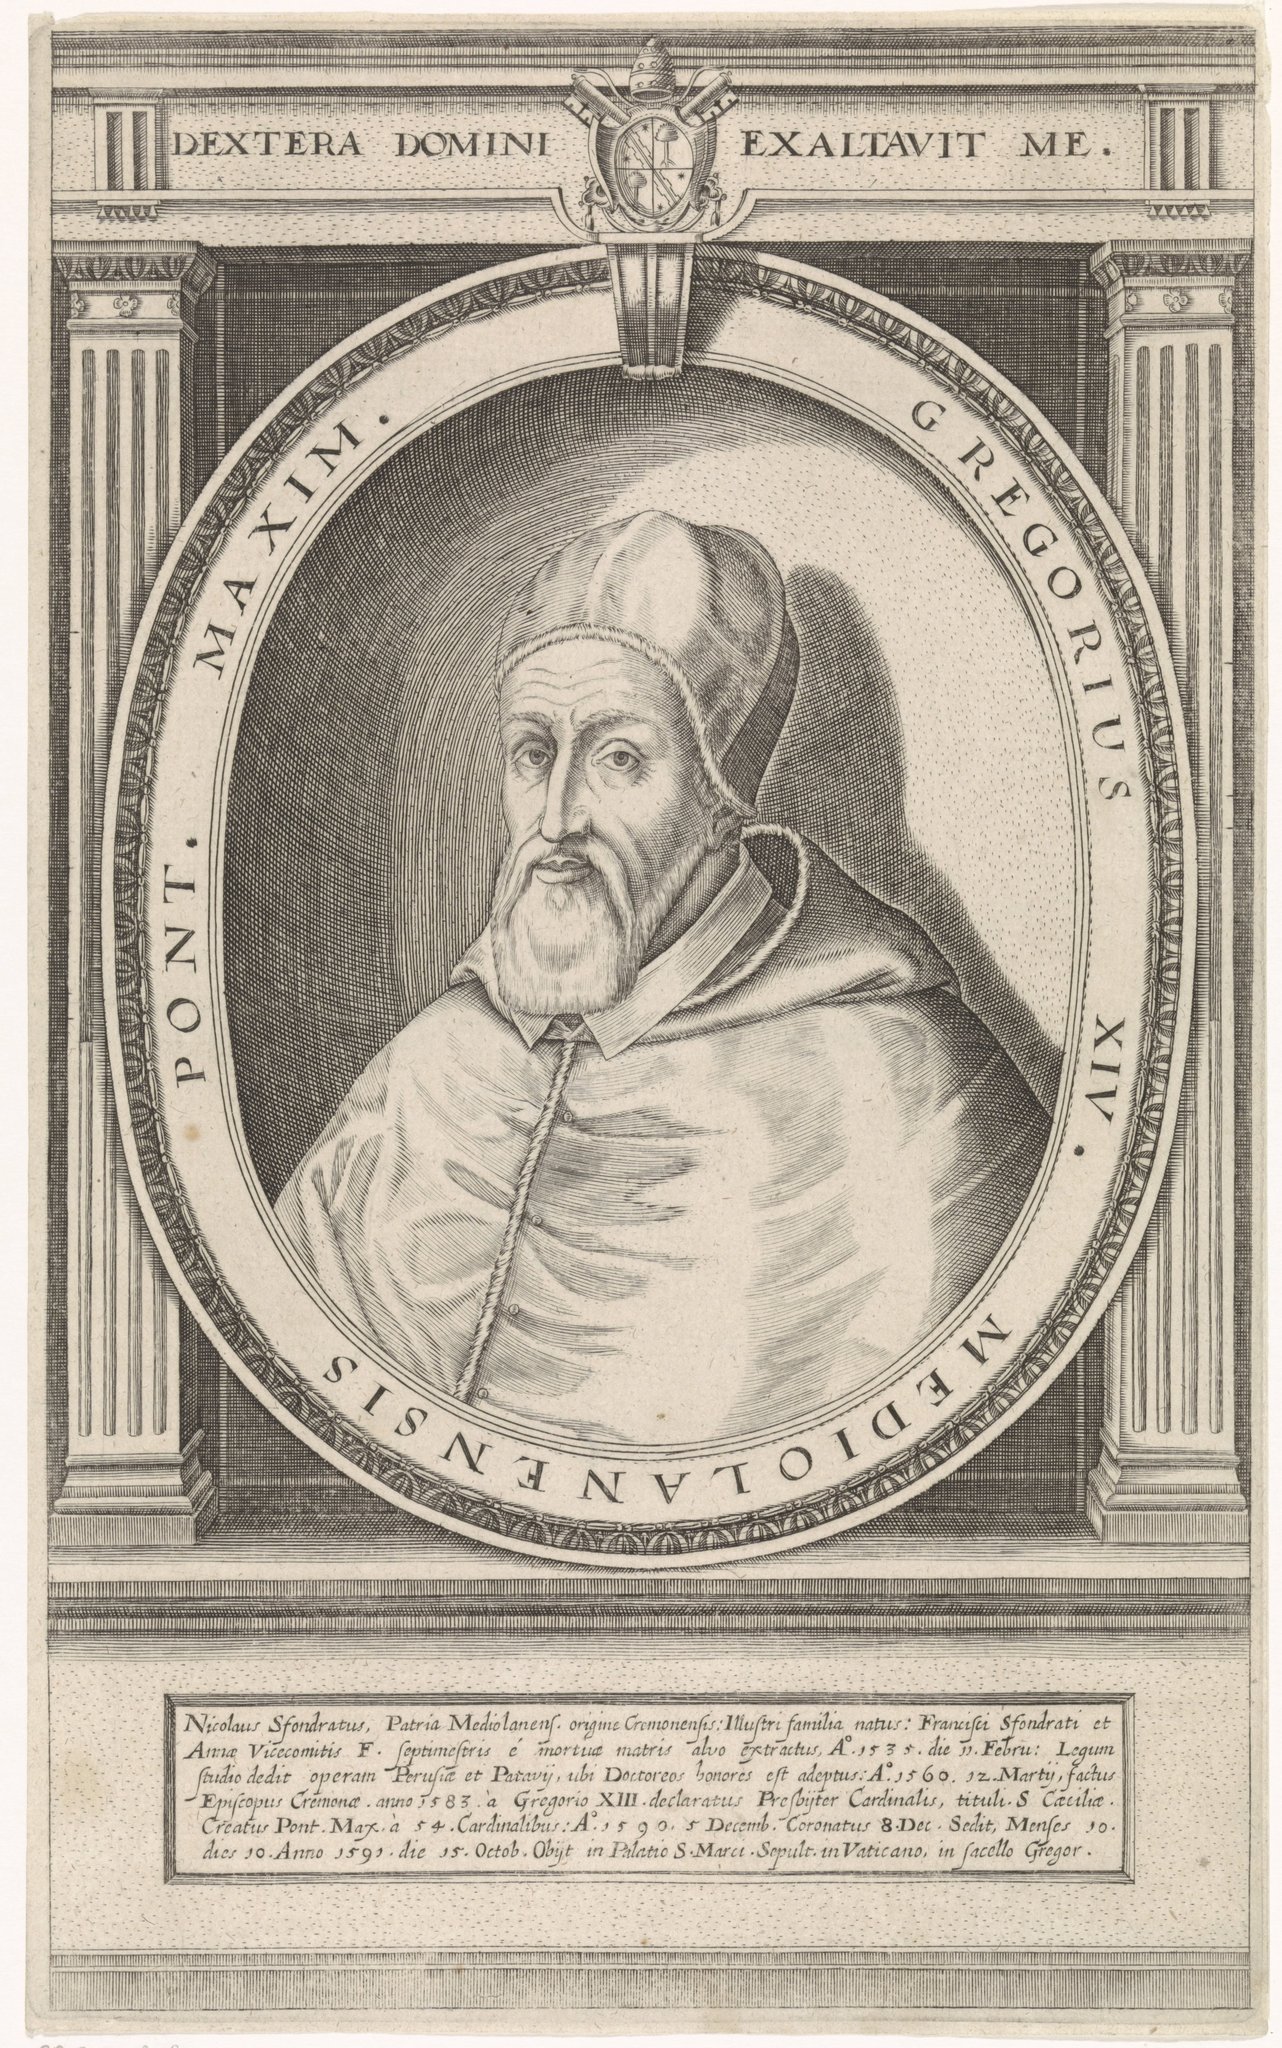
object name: print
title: Portret van paus Gregorius XIV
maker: friedrich van hulsen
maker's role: print maker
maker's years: 1580-1660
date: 1590-1665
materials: paper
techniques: engraving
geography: germany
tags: rome, gregorius xiv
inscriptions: collector's mark: Lugt 2228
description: Portret van paus Gregorius XIV gehuld in het pauselijk gewaad, het hoofd getooid met een camauro. Buste naar links in een ovale lijst met randschrift. Boven een tekstregel in het Latijn en midden boven is zijn pauselijk wapen afgebeeld. Onder het portret zes tekstregels in het Latijn.